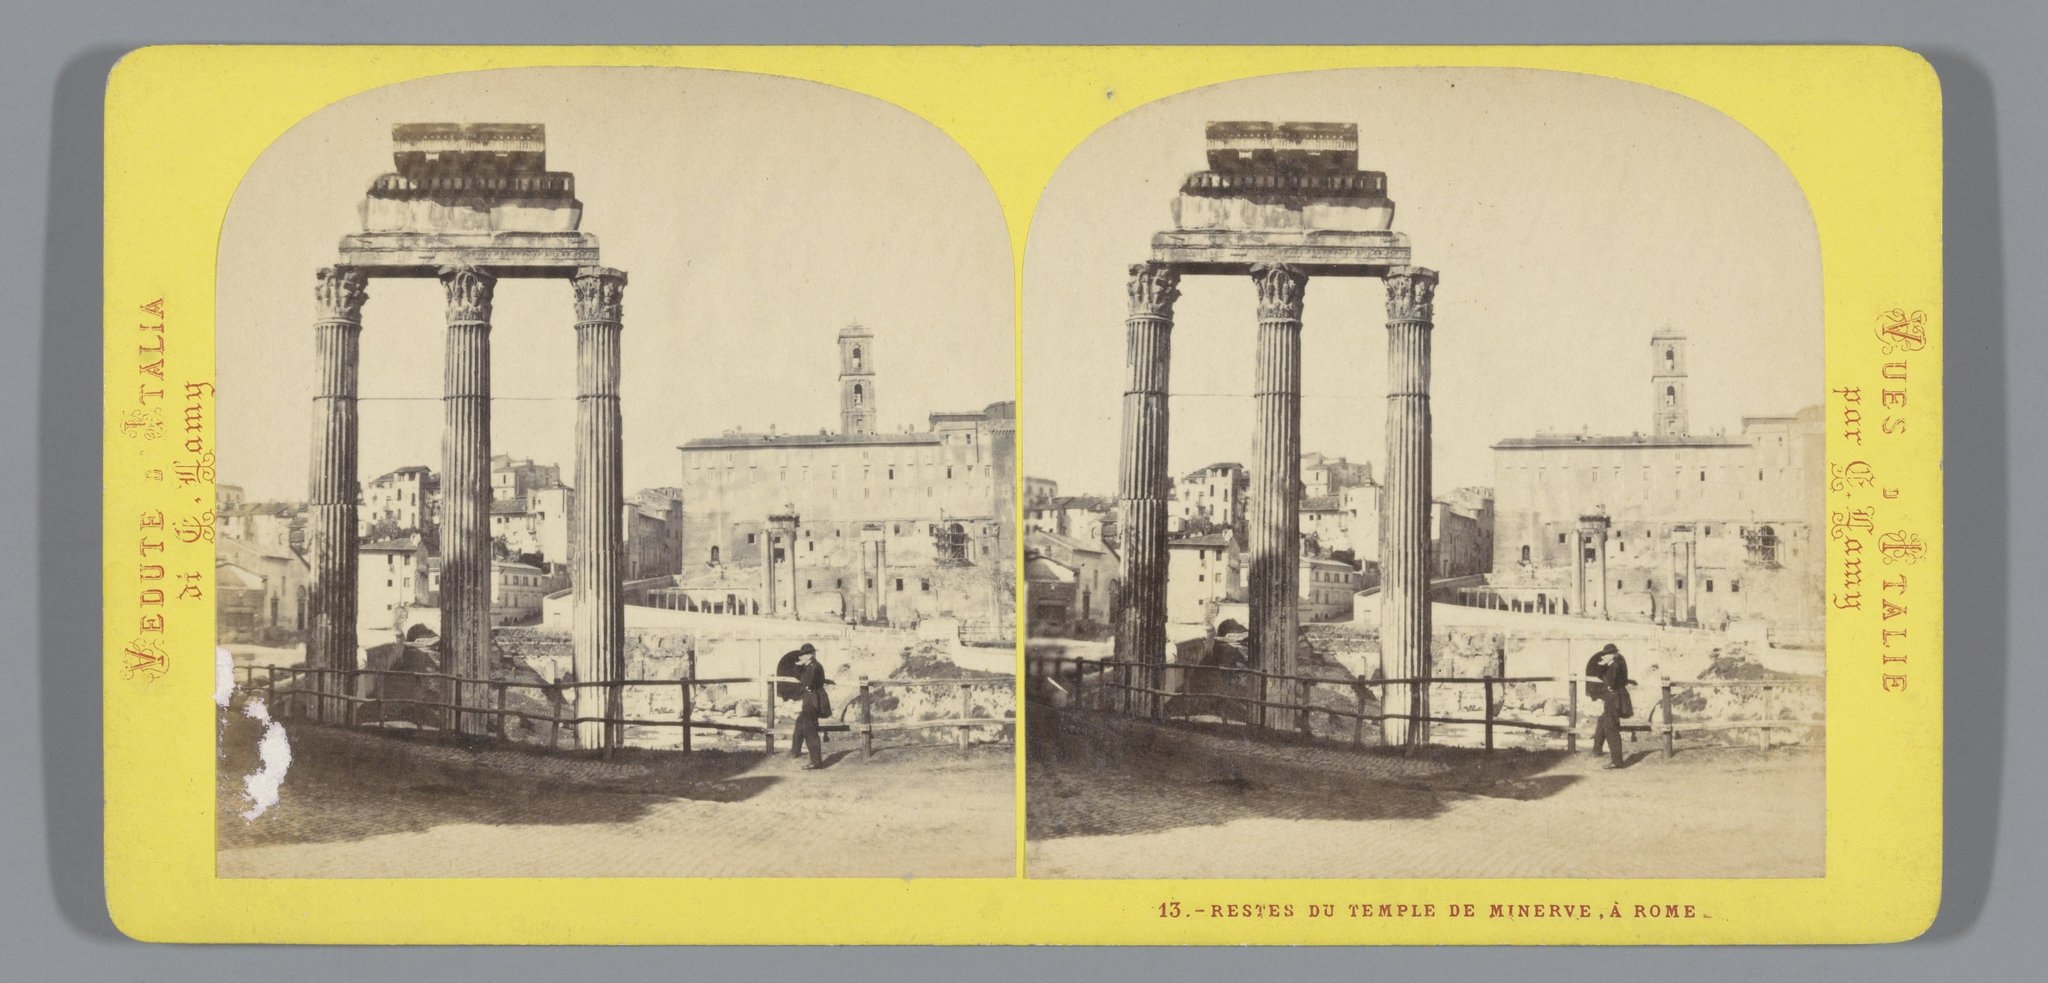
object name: stereograph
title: Zuilen van de Tempel van Castor en Pollux, Rome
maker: ernest eléonor pierre lamy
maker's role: publisher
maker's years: 1828-1900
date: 1861-1878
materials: cardboard, paper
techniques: albumen print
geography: rome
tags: column, pillar ~ architecture, temple, shrine ~ roman religion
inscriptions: number: ‘13.’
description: In tegenstelling tot het bijschrift op de foto gaat het hier niet om overblijfselen van de Tempel van Minerva maar om de Tempel van Castor en Pollux.